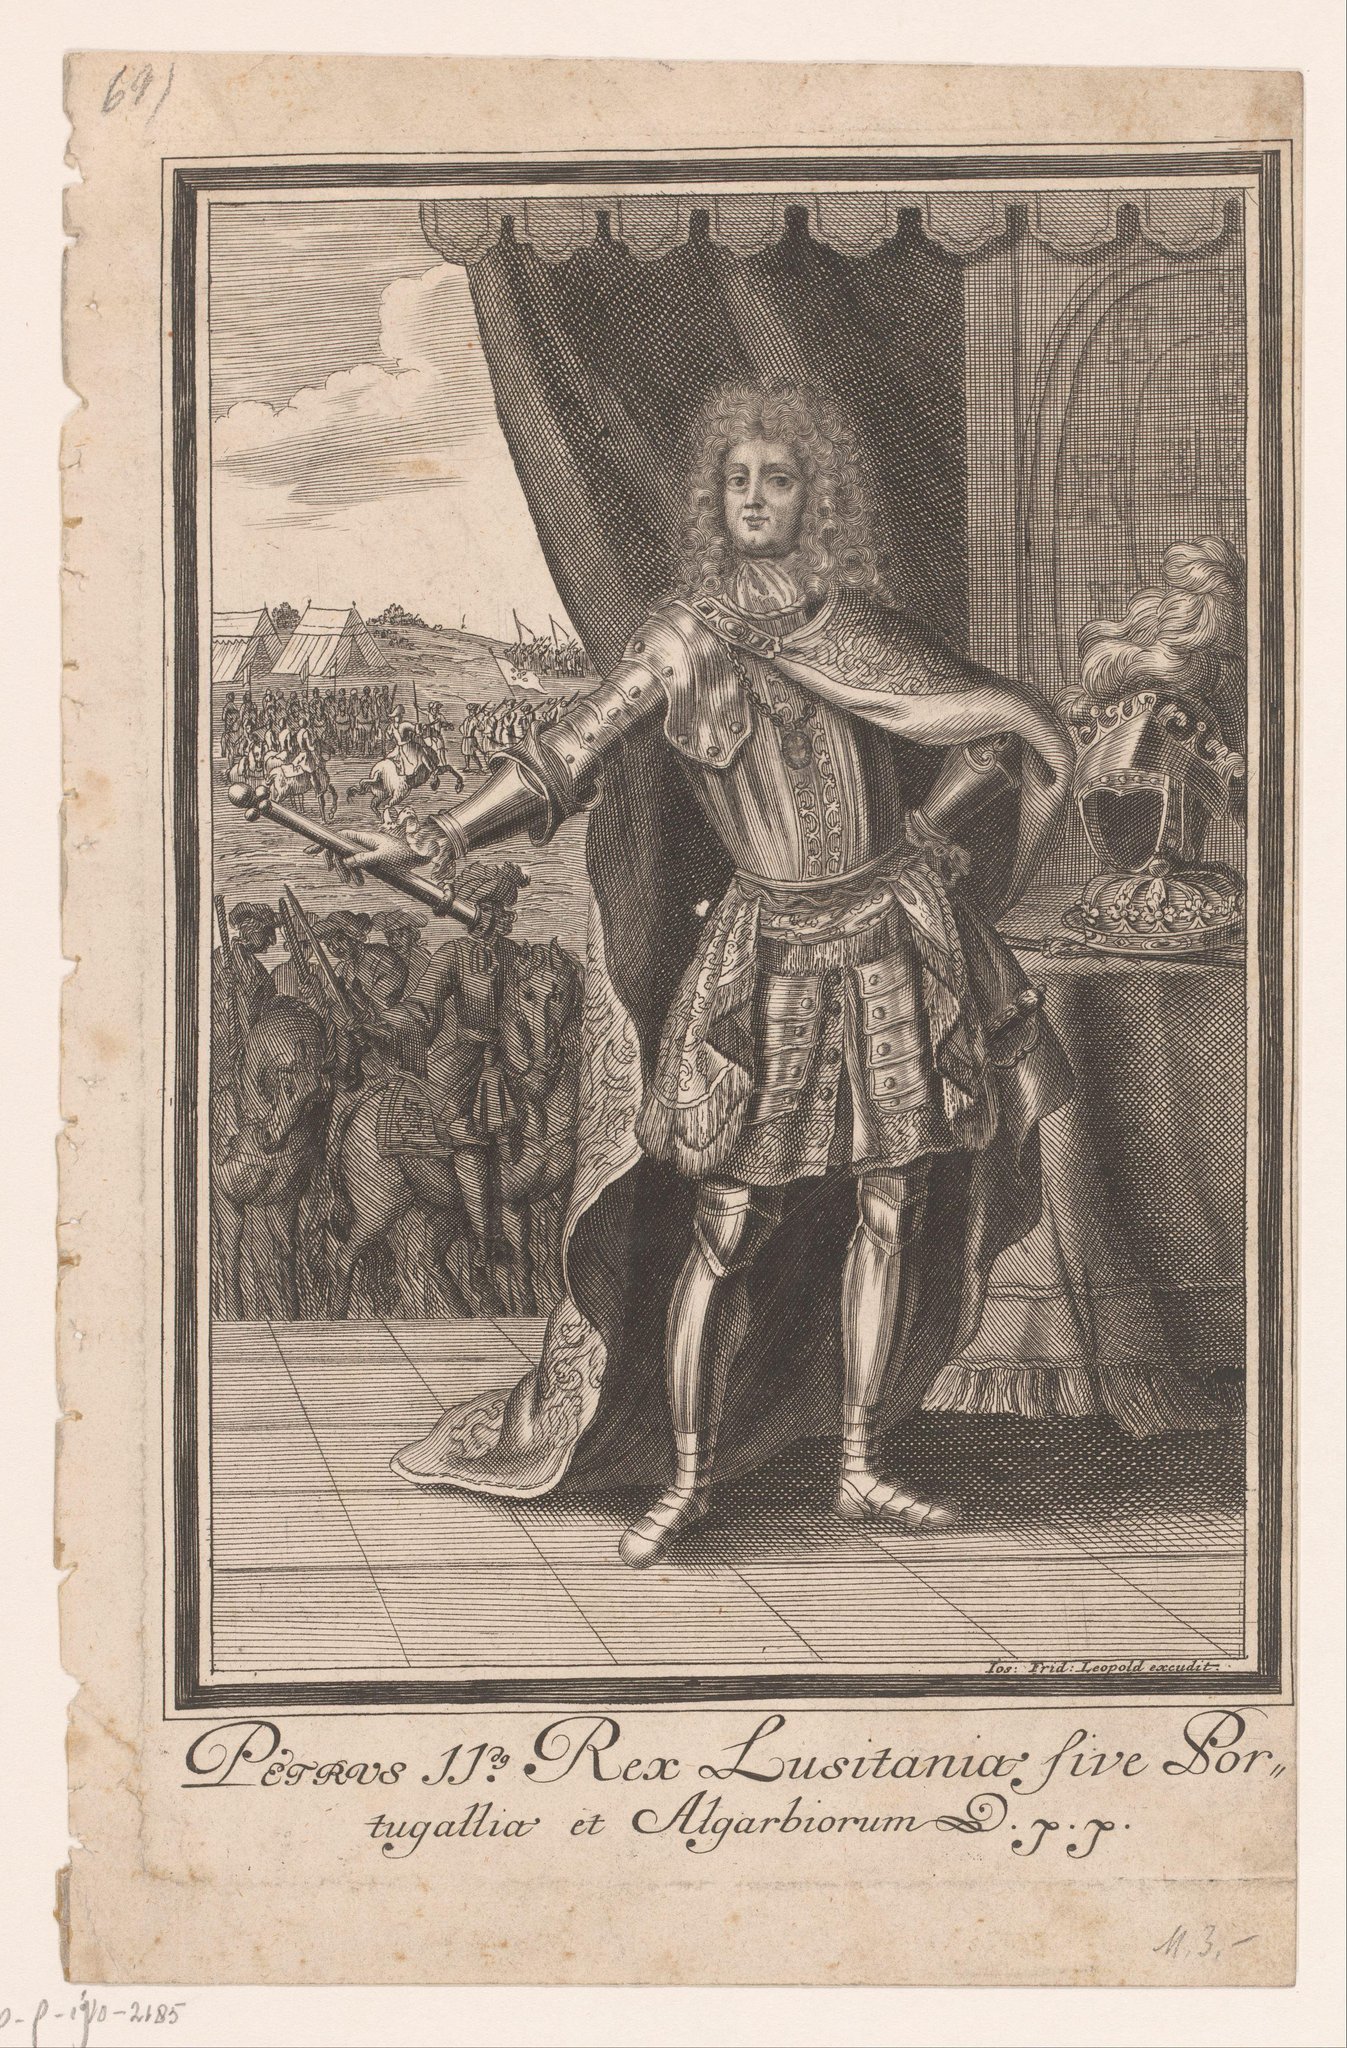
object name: print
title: Portret van Peter II, koning van Portugal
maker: joseph friedrich leopold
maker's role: print maker, publisher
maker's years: 1668-1726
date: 1678-1726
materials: paper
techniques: engraving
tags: historical persons, land forces, insignia and symbols of sovereignty (crown, diadem, sceptre, orb, seal, standard, cloak, pectoral)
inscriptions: collector's mark: Lugt 2228